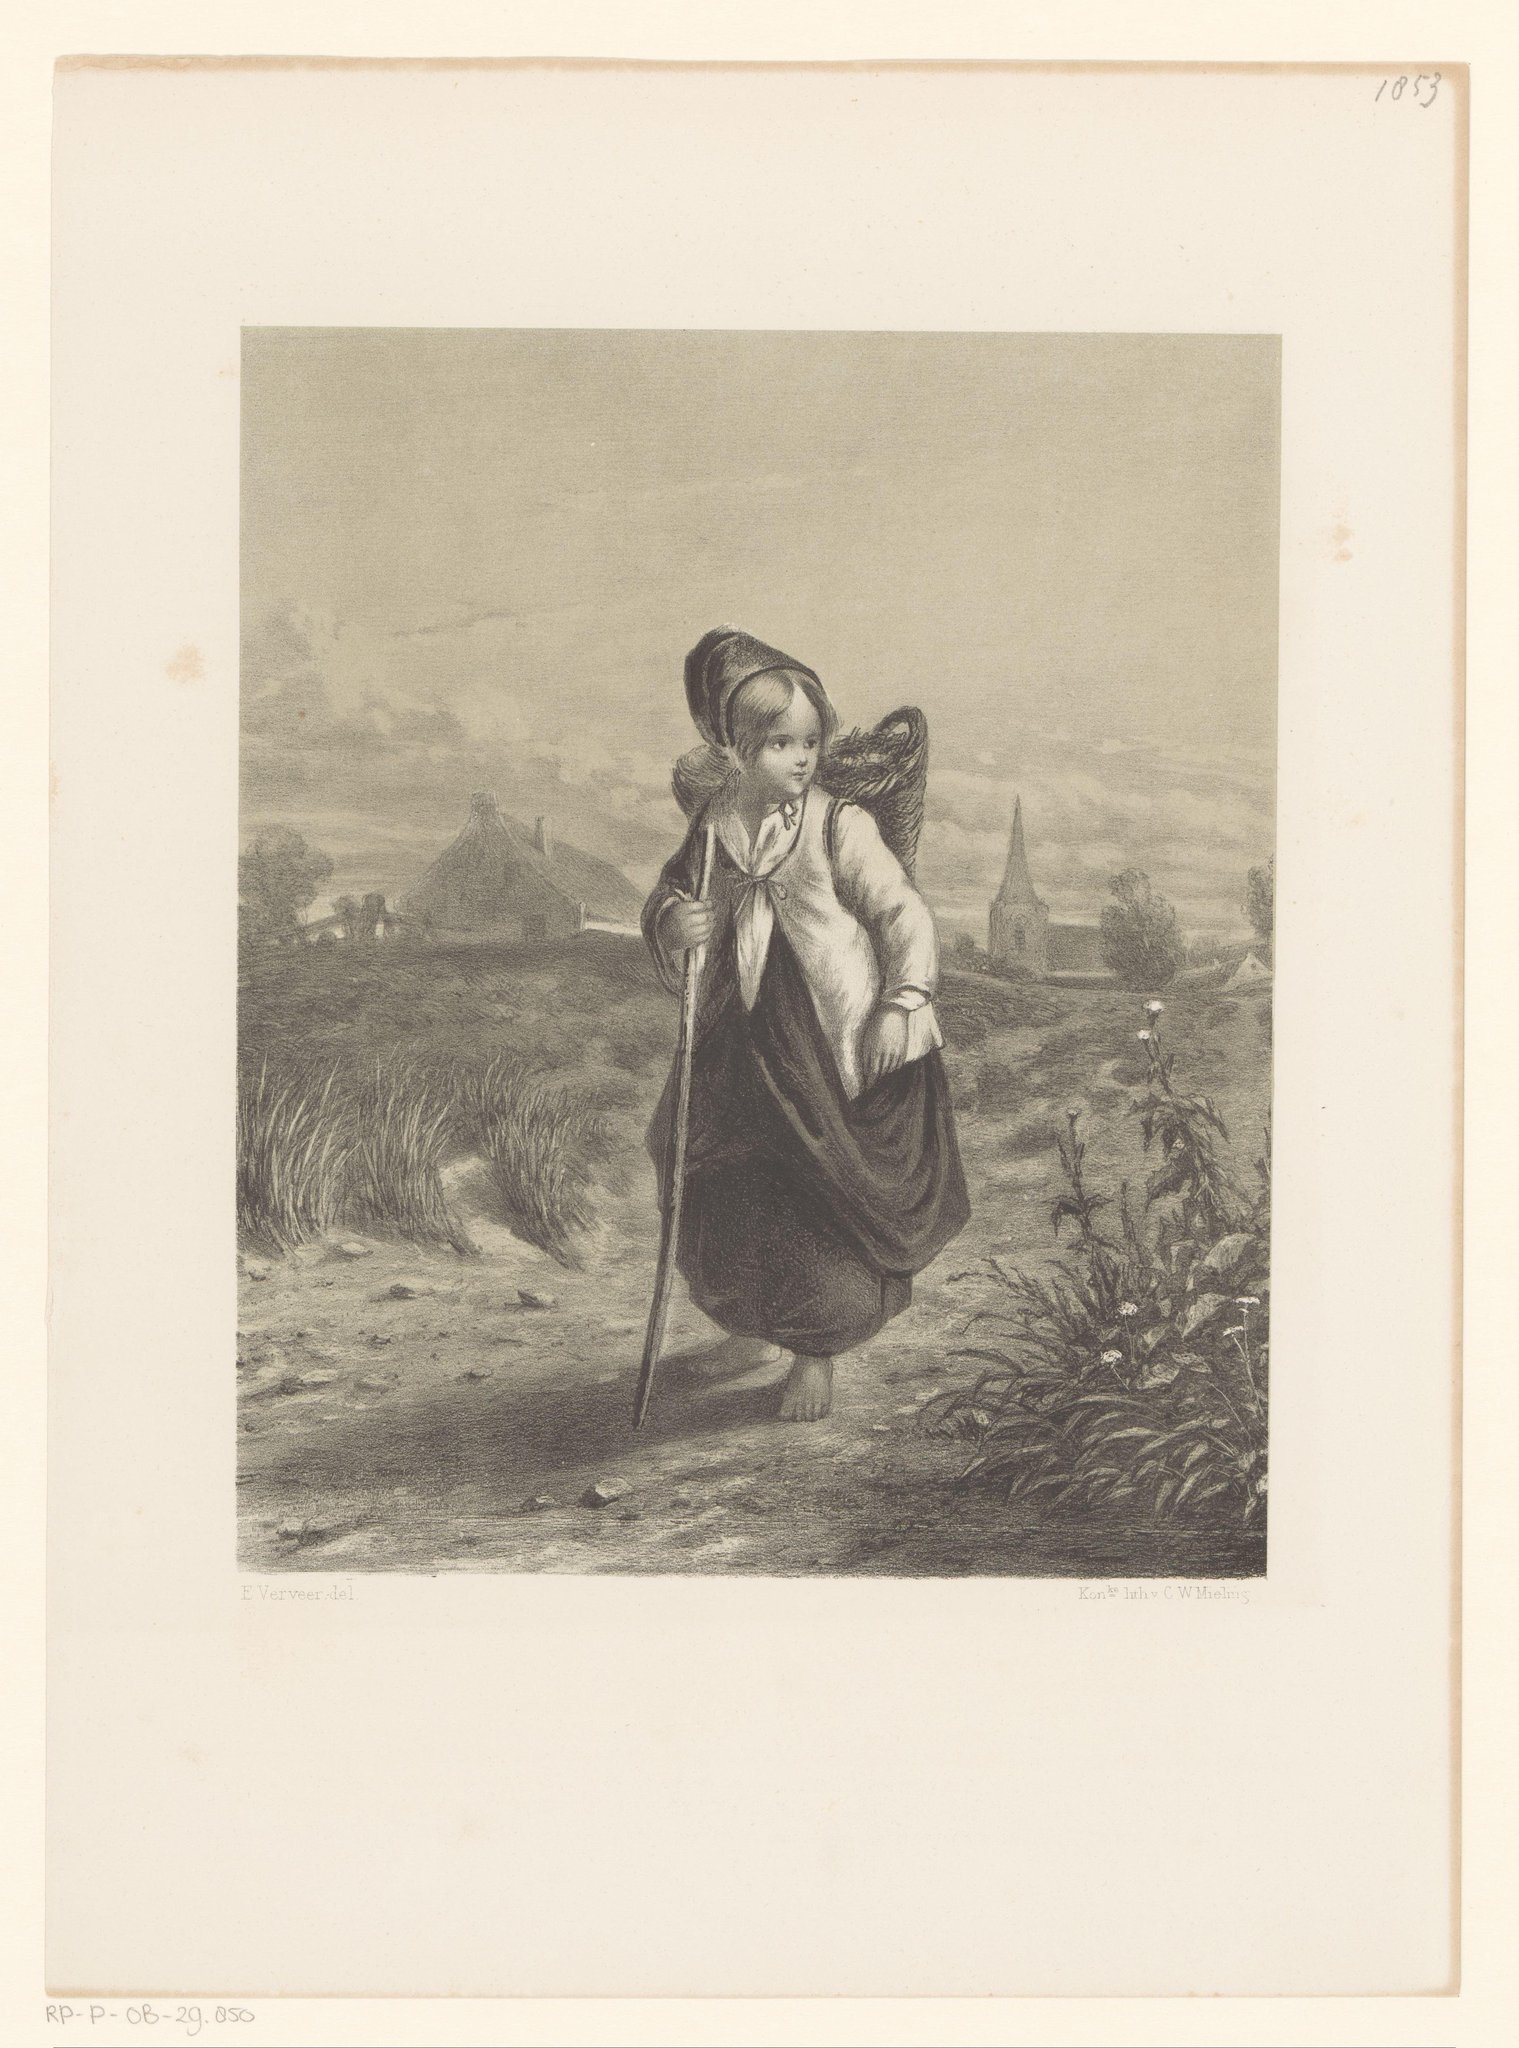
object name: print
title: Meisje met mand op de rug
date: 1847-1865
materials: paper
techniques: tone lithography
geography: the hague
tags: carrying something in basket, bag, rucksack, etc., girl (child between toddler and youth)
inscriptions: collector's mark: Lugt 2228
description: Op een pad loopt een meisje met een mand op haar rug en een stok in haar hand.